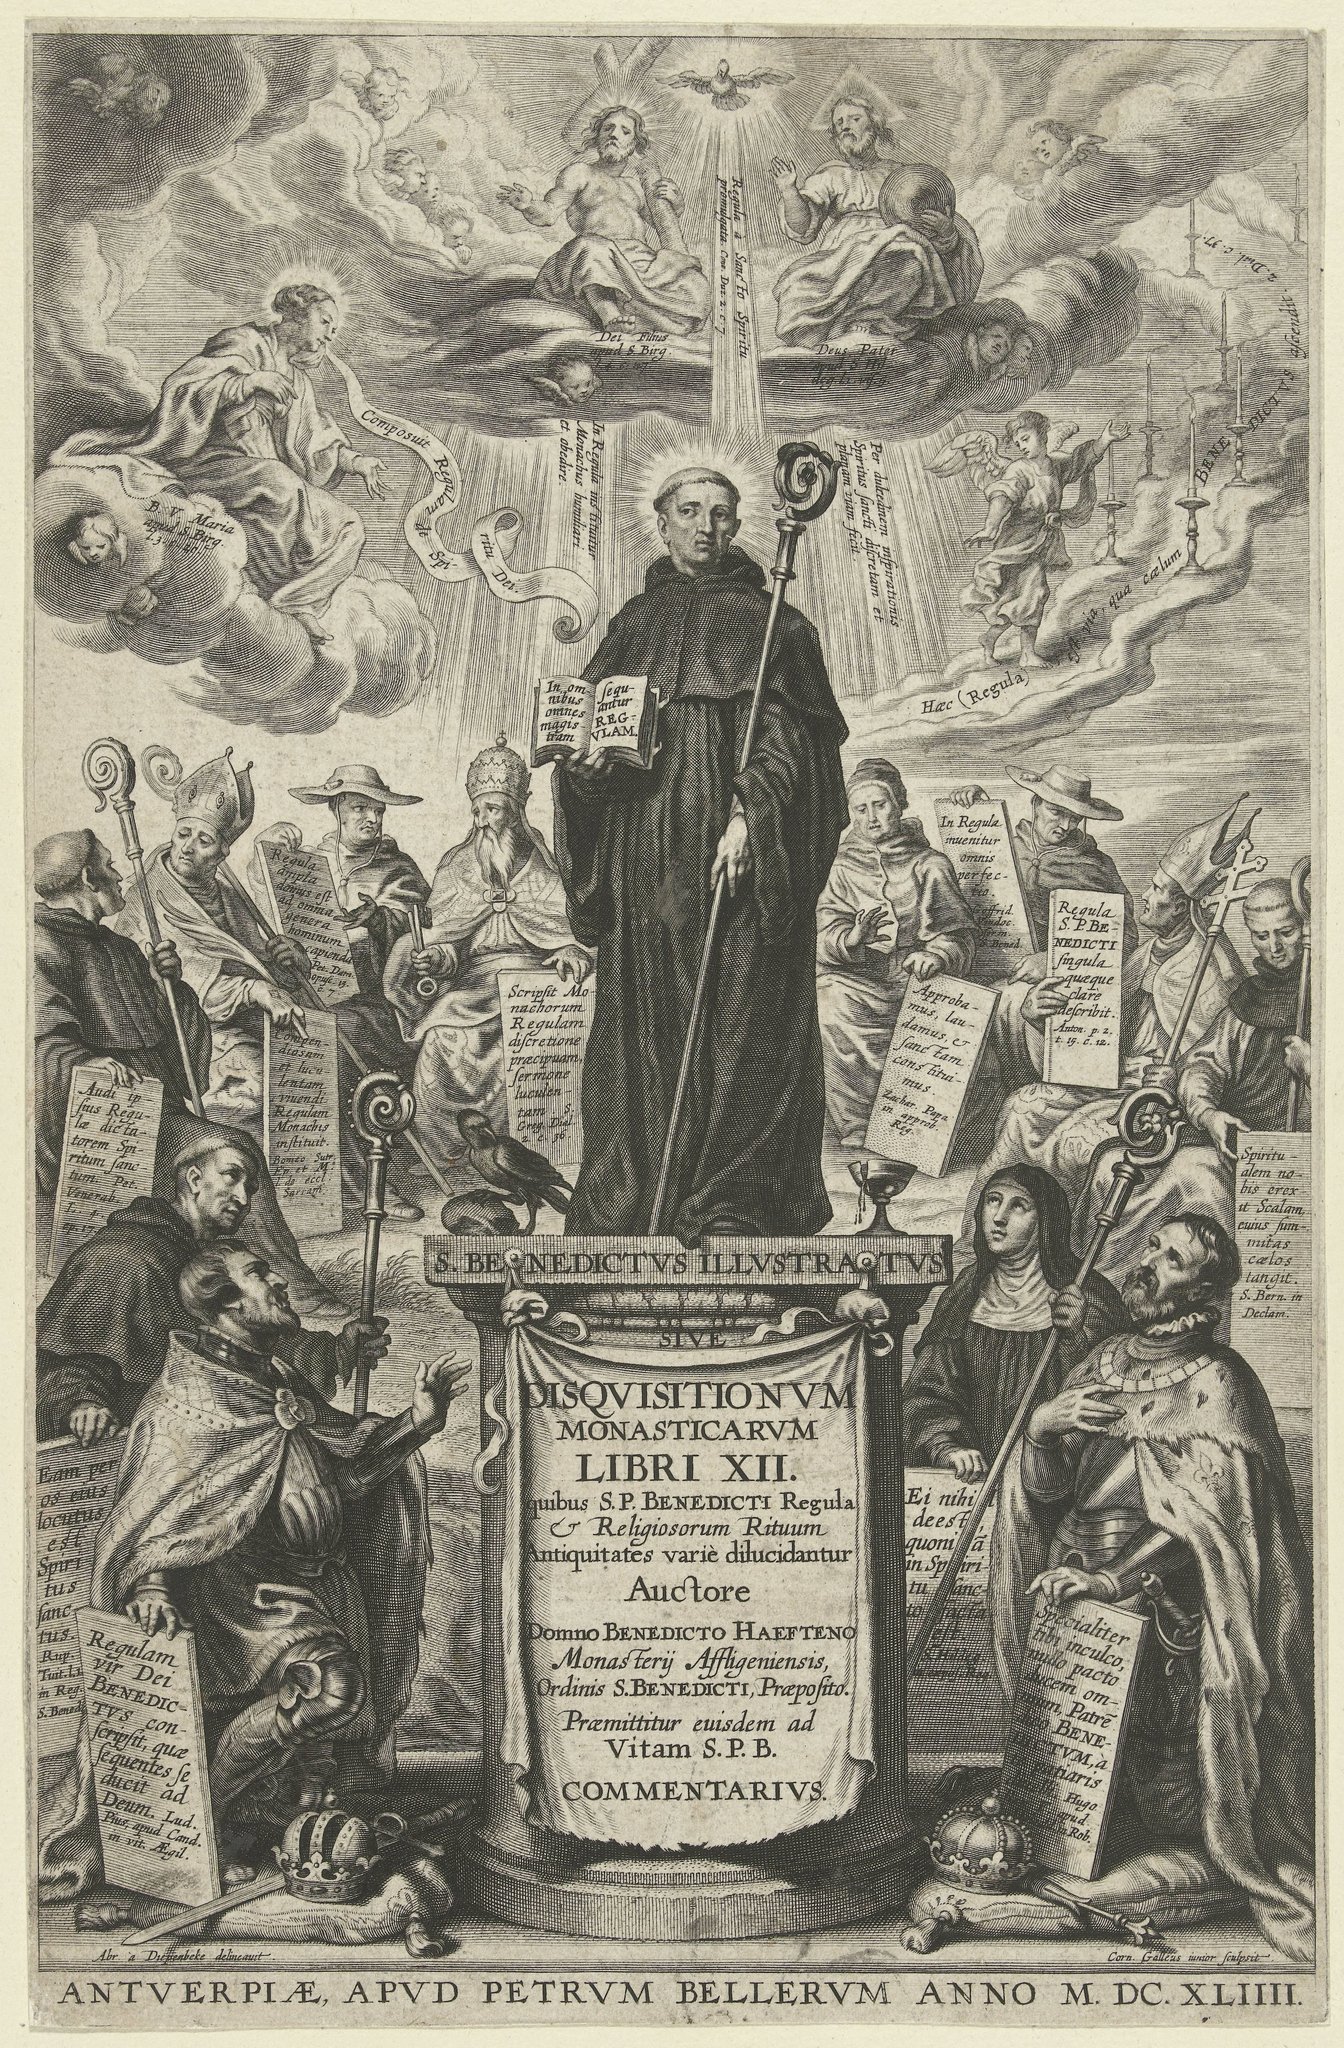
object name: print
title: Titelpagina voor: Benedictus van Haeften, S. Benedictvs illvstratvs sive Disqvisitionvm monasticarvm libri XII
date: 1644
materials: paper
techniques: engraving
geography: antwerp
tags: benedict of nurcia, abbot of monte cassino and founder of the benedictine order; possible attributes: aspergillum, book, cup (sometimes broken), raven with loaf, sieve (or tray), trinity in which god the father and christ are represented as persons, the holy ghost as dove, monastic orders, monastic life ~ roman catholic church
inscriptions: collector's mark: Lugt 240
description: De heilige Benedictus met bisschopsstaf en boek staand op een sokkel, omgeven door stichters van de overige kloosterordes. Aan weerszijden van de sokkel twee wereldlijke leiders, knielend. In de hemel Christus, God de Vader en de Heilige Geest in de gedaante van een duif.